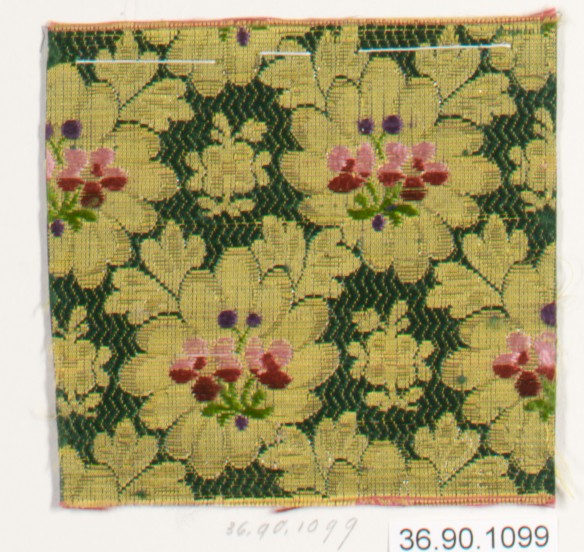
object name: sample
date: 1701-1900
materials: metal thread, silk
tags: flowers,leaves